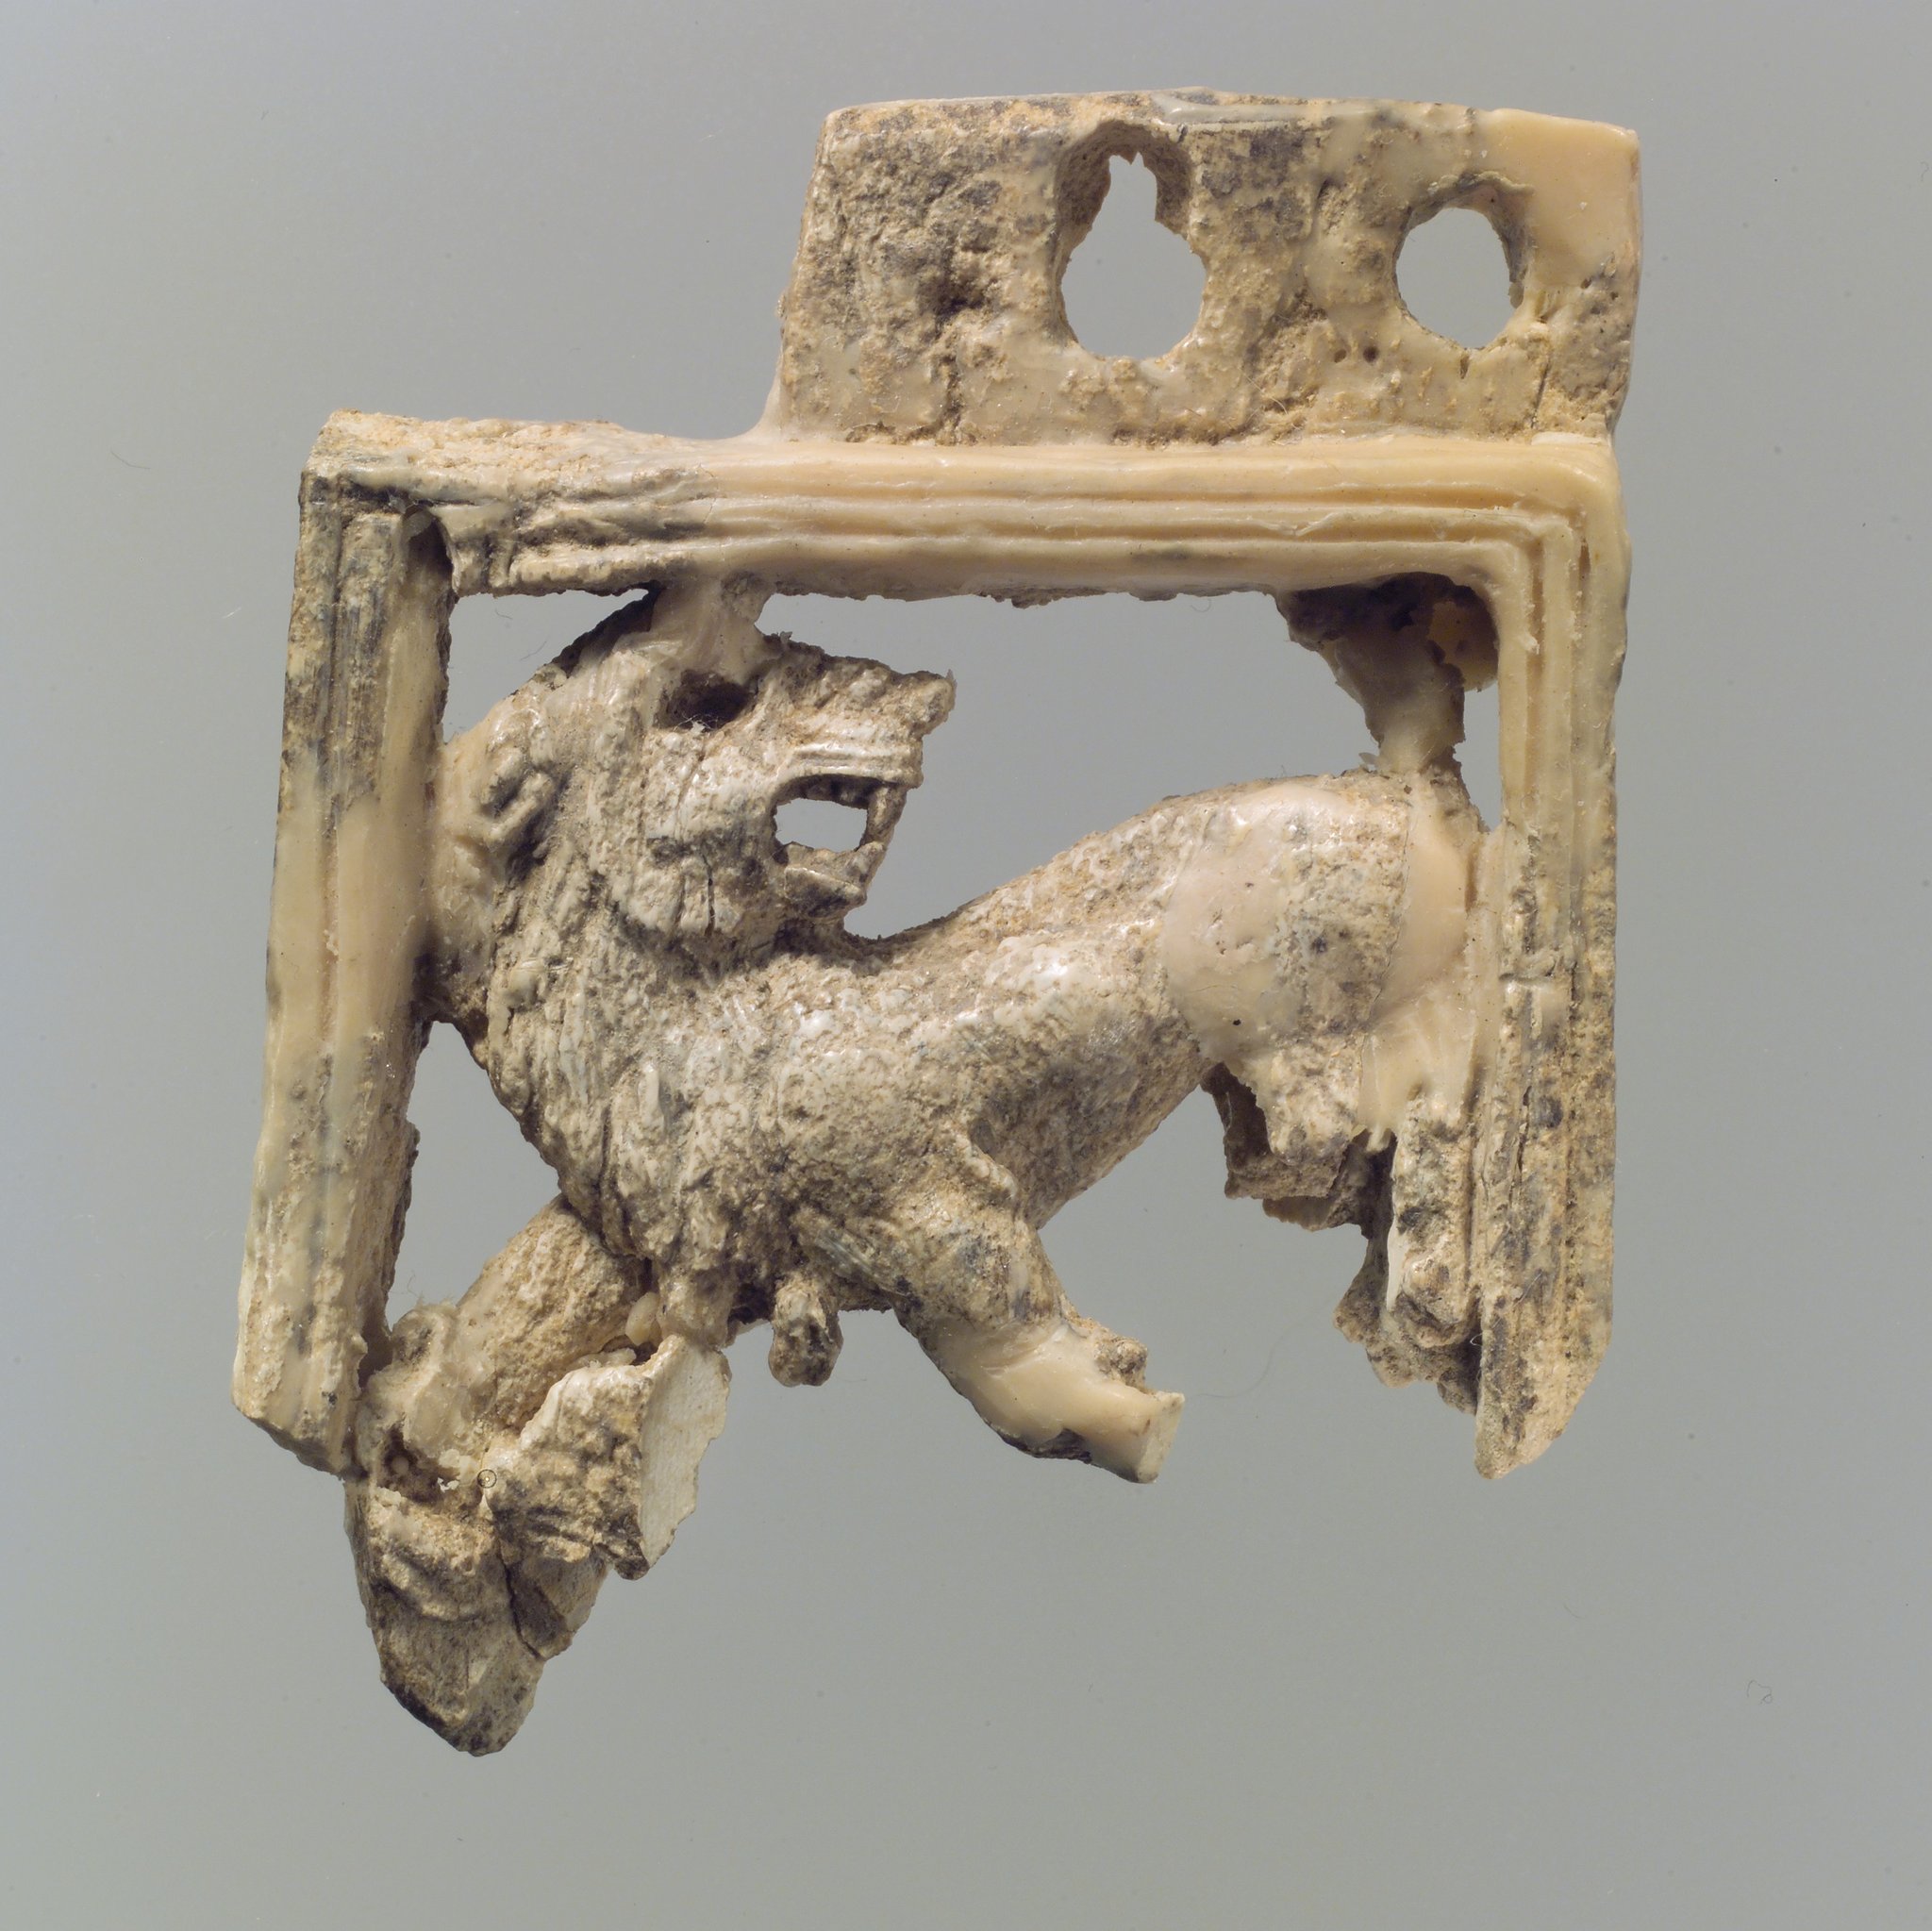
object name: relief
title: Openwork furniture plaque with lion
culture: assyrian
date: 900-701 BCE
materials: ivory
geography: mesopotamia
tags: lions